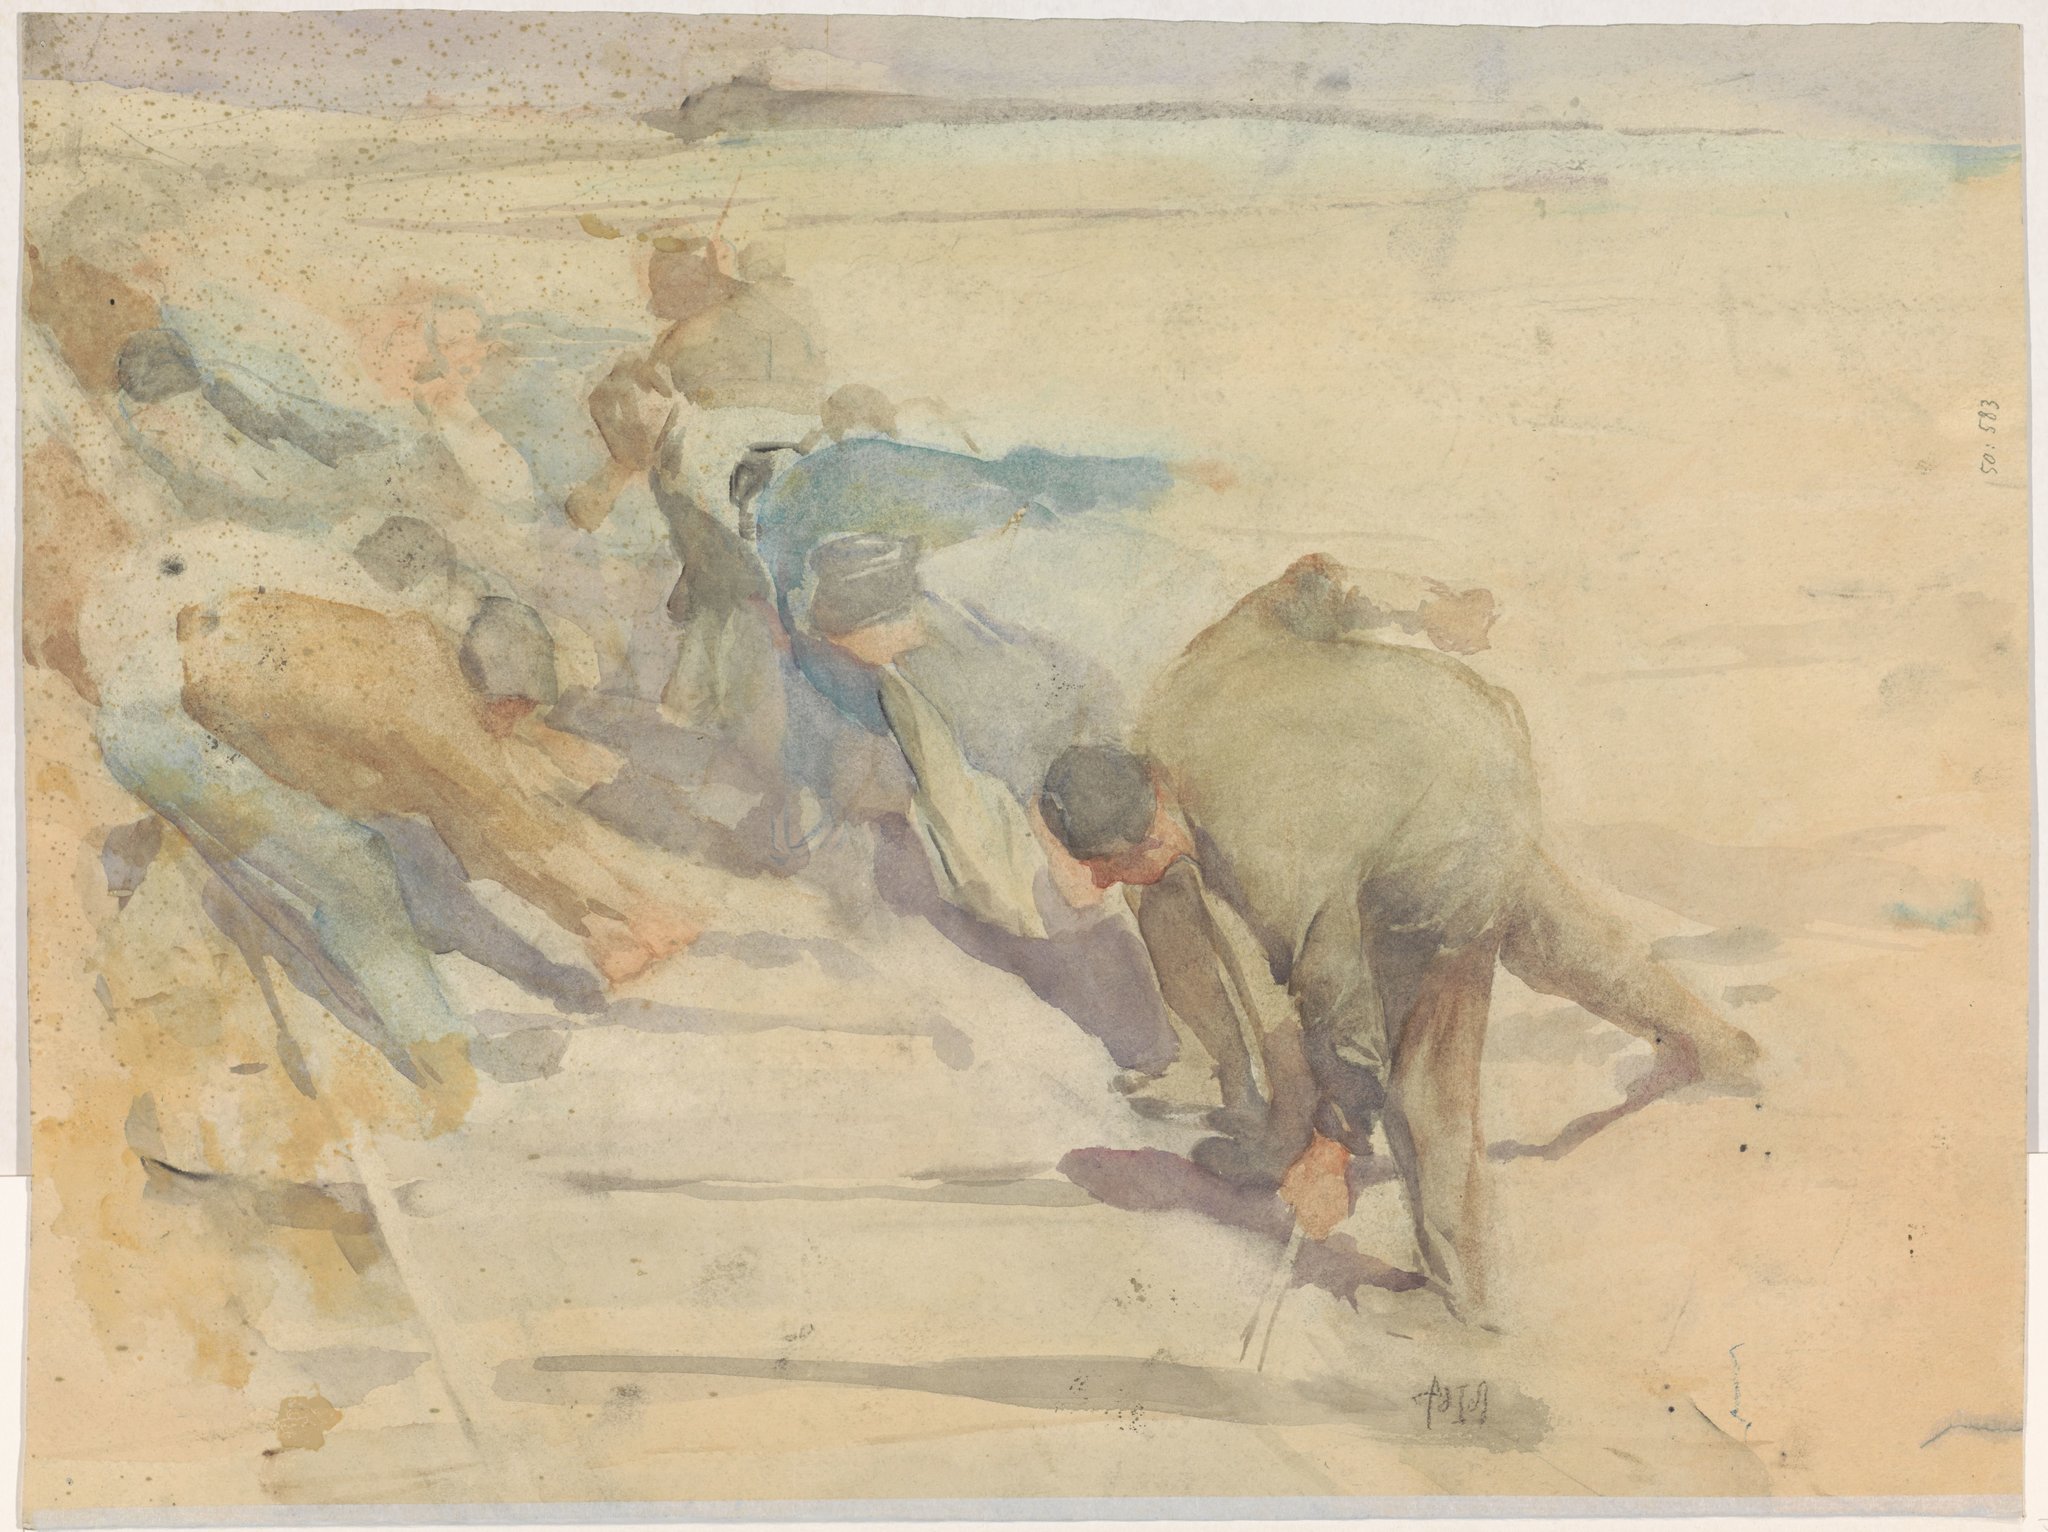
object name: watercolor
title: Arbeiders bezig met het opbreken van rails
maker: pieter de josselin de jong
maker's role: draughtsman, painter, print maker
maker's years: 1861-1906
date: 1871-1906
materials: chalk, paper, watercolor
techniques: brush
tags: working class, labourers, railway, tramway; rack railway